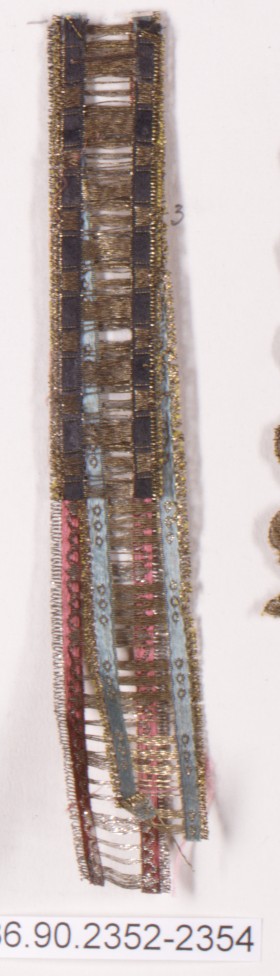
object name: ribbon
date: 1801-1900